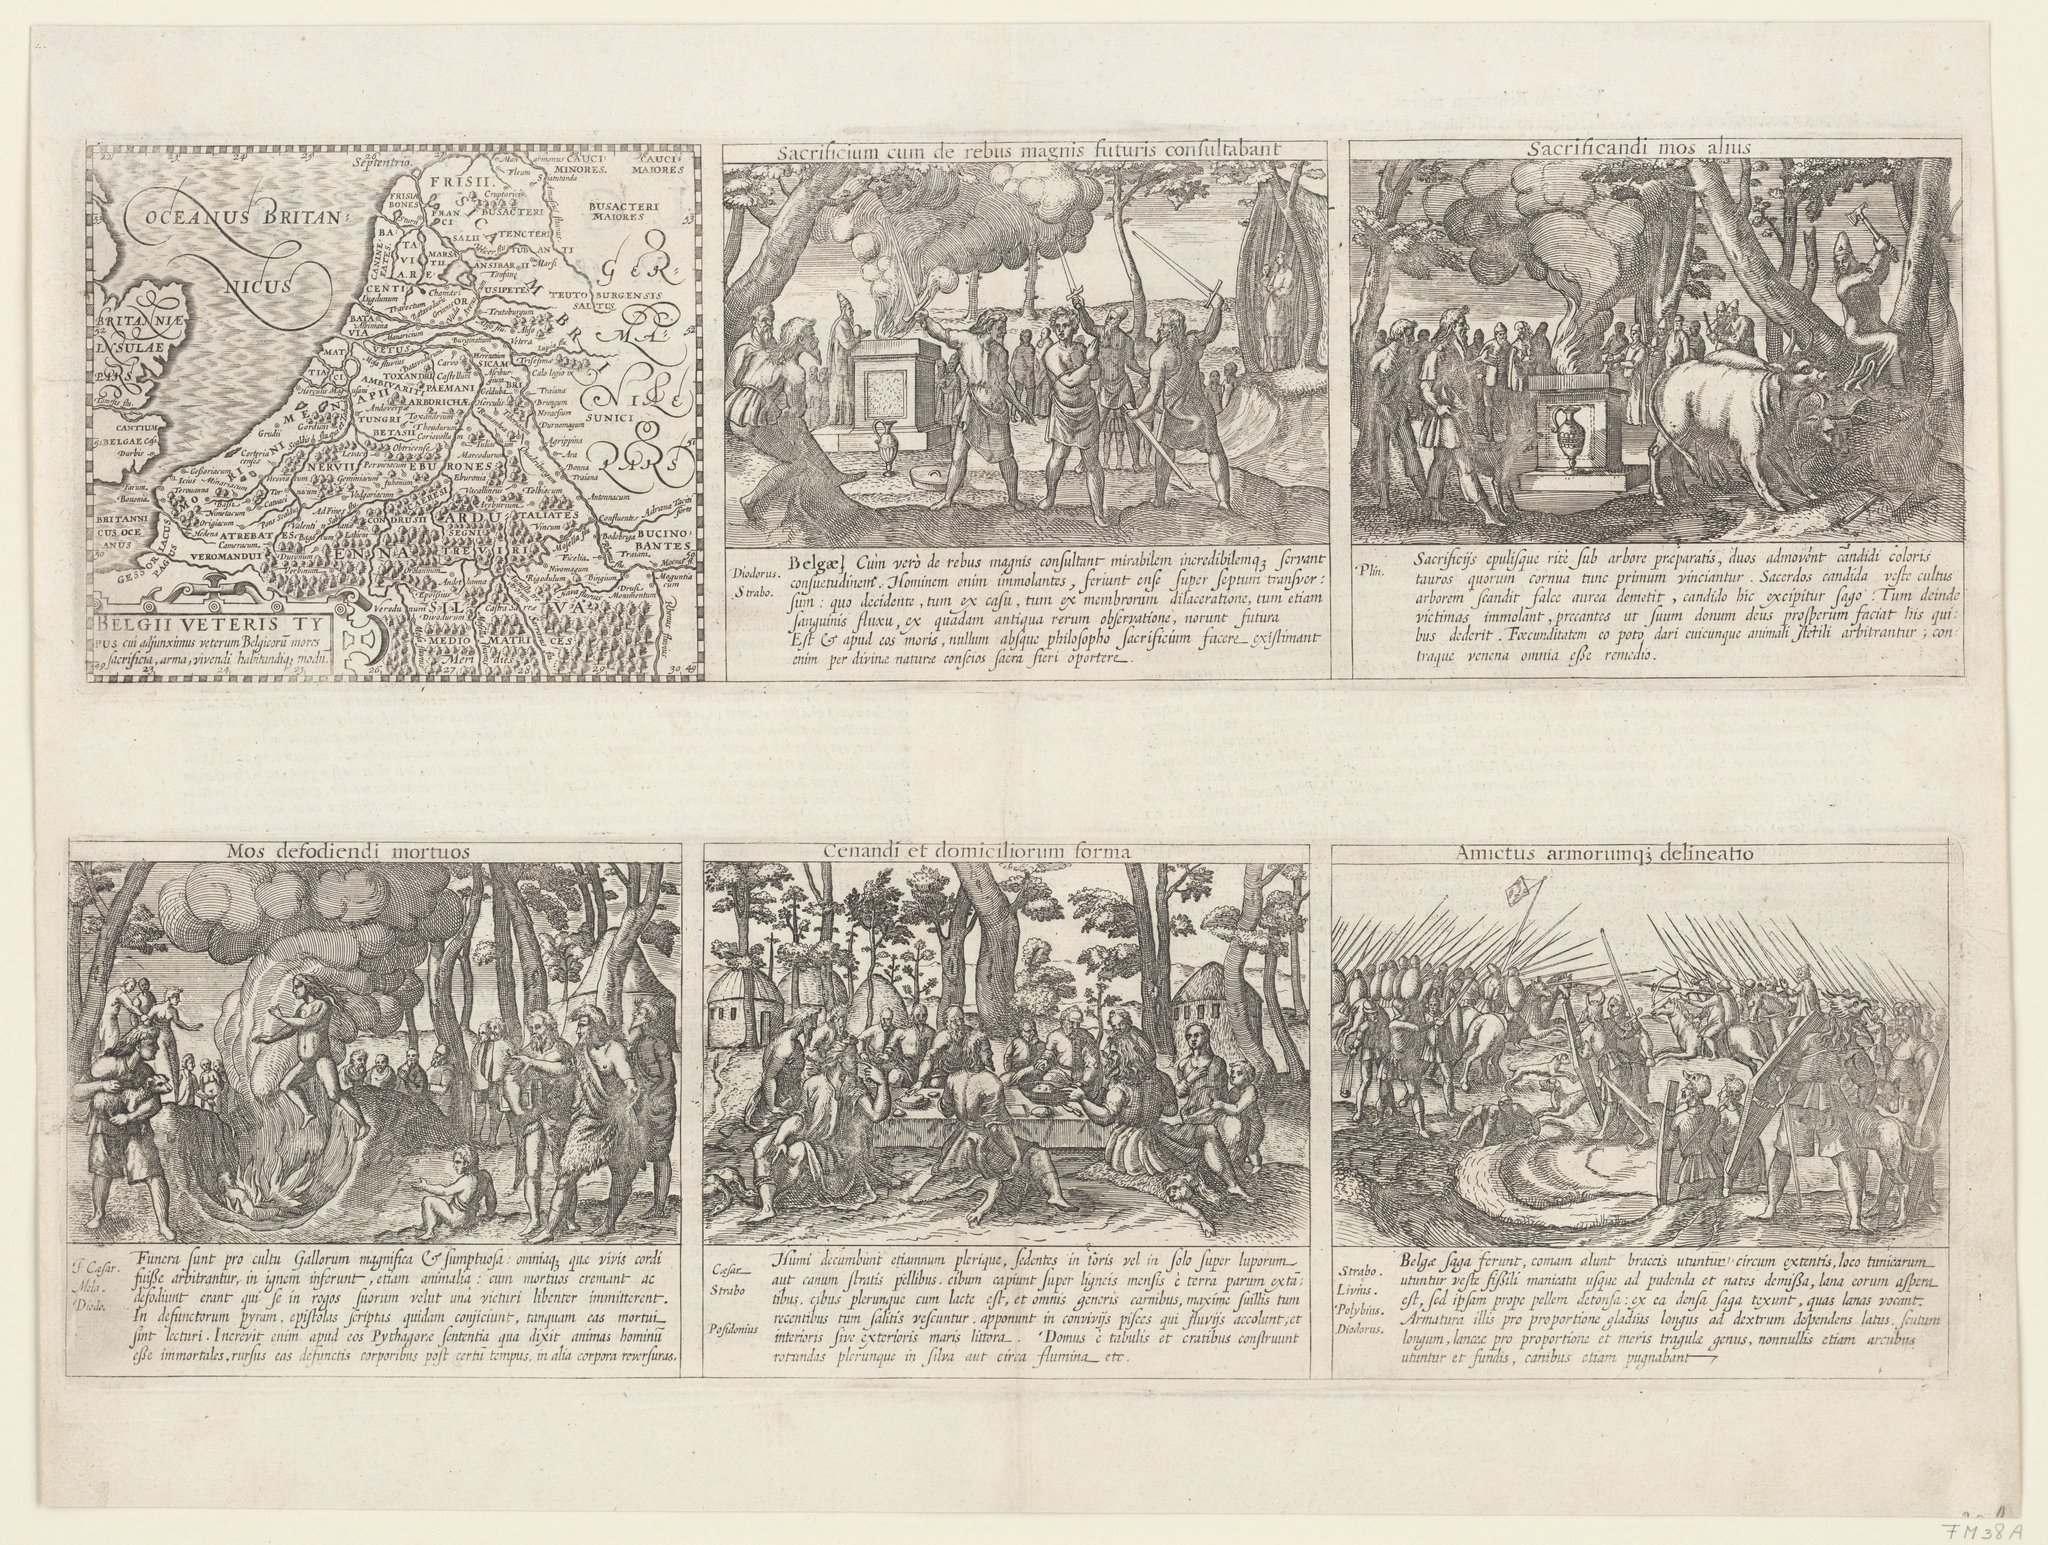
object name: history print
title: Zeden van de oude Germanen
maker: pieter van der keere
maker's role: print maker, publisher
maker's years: 1571-1646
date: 1615-1617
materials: paper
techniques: etching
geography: netherlands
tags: extinct, 'historical' peoples (with name), netherlands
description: Blad met zes afzonderlijke voorstellingen, gedrukt van twee platen met elk drie scènes. Kaartje van Nederland met omringende landen en vijf voorstellingen met Latijnse onderschriften van de Germaanse gewoonten bij offerplechtigheden, maaltijden, begrafenis en oorlog. Blad uit een boek genomen, met op de achterzijde tekst. Afkomstig uit: Pieter van den Keere, Germania inferior id est, XVII provinciarum ejus novæ et exactæ tabulæ geographicæ, Pieter van den Keere, Amsterdam 1617-1622.